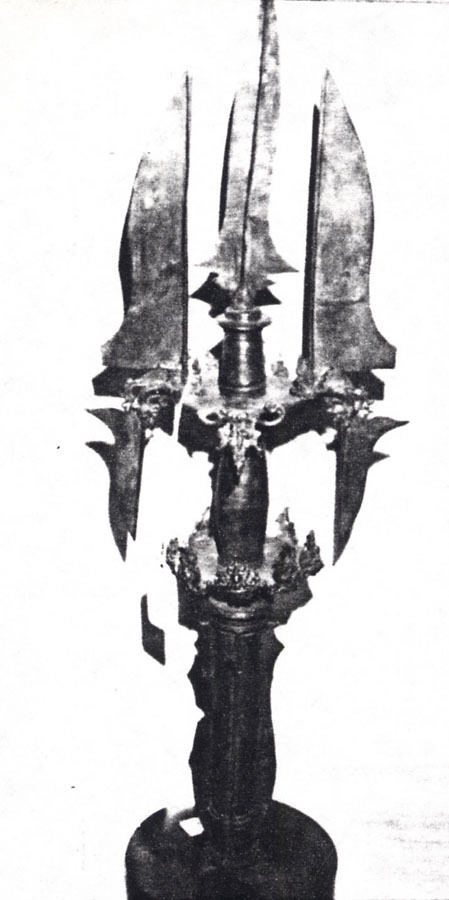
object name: halberd head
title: Halberd Head with Five Blades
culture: indonesian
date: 1251-1300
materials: copper alloy